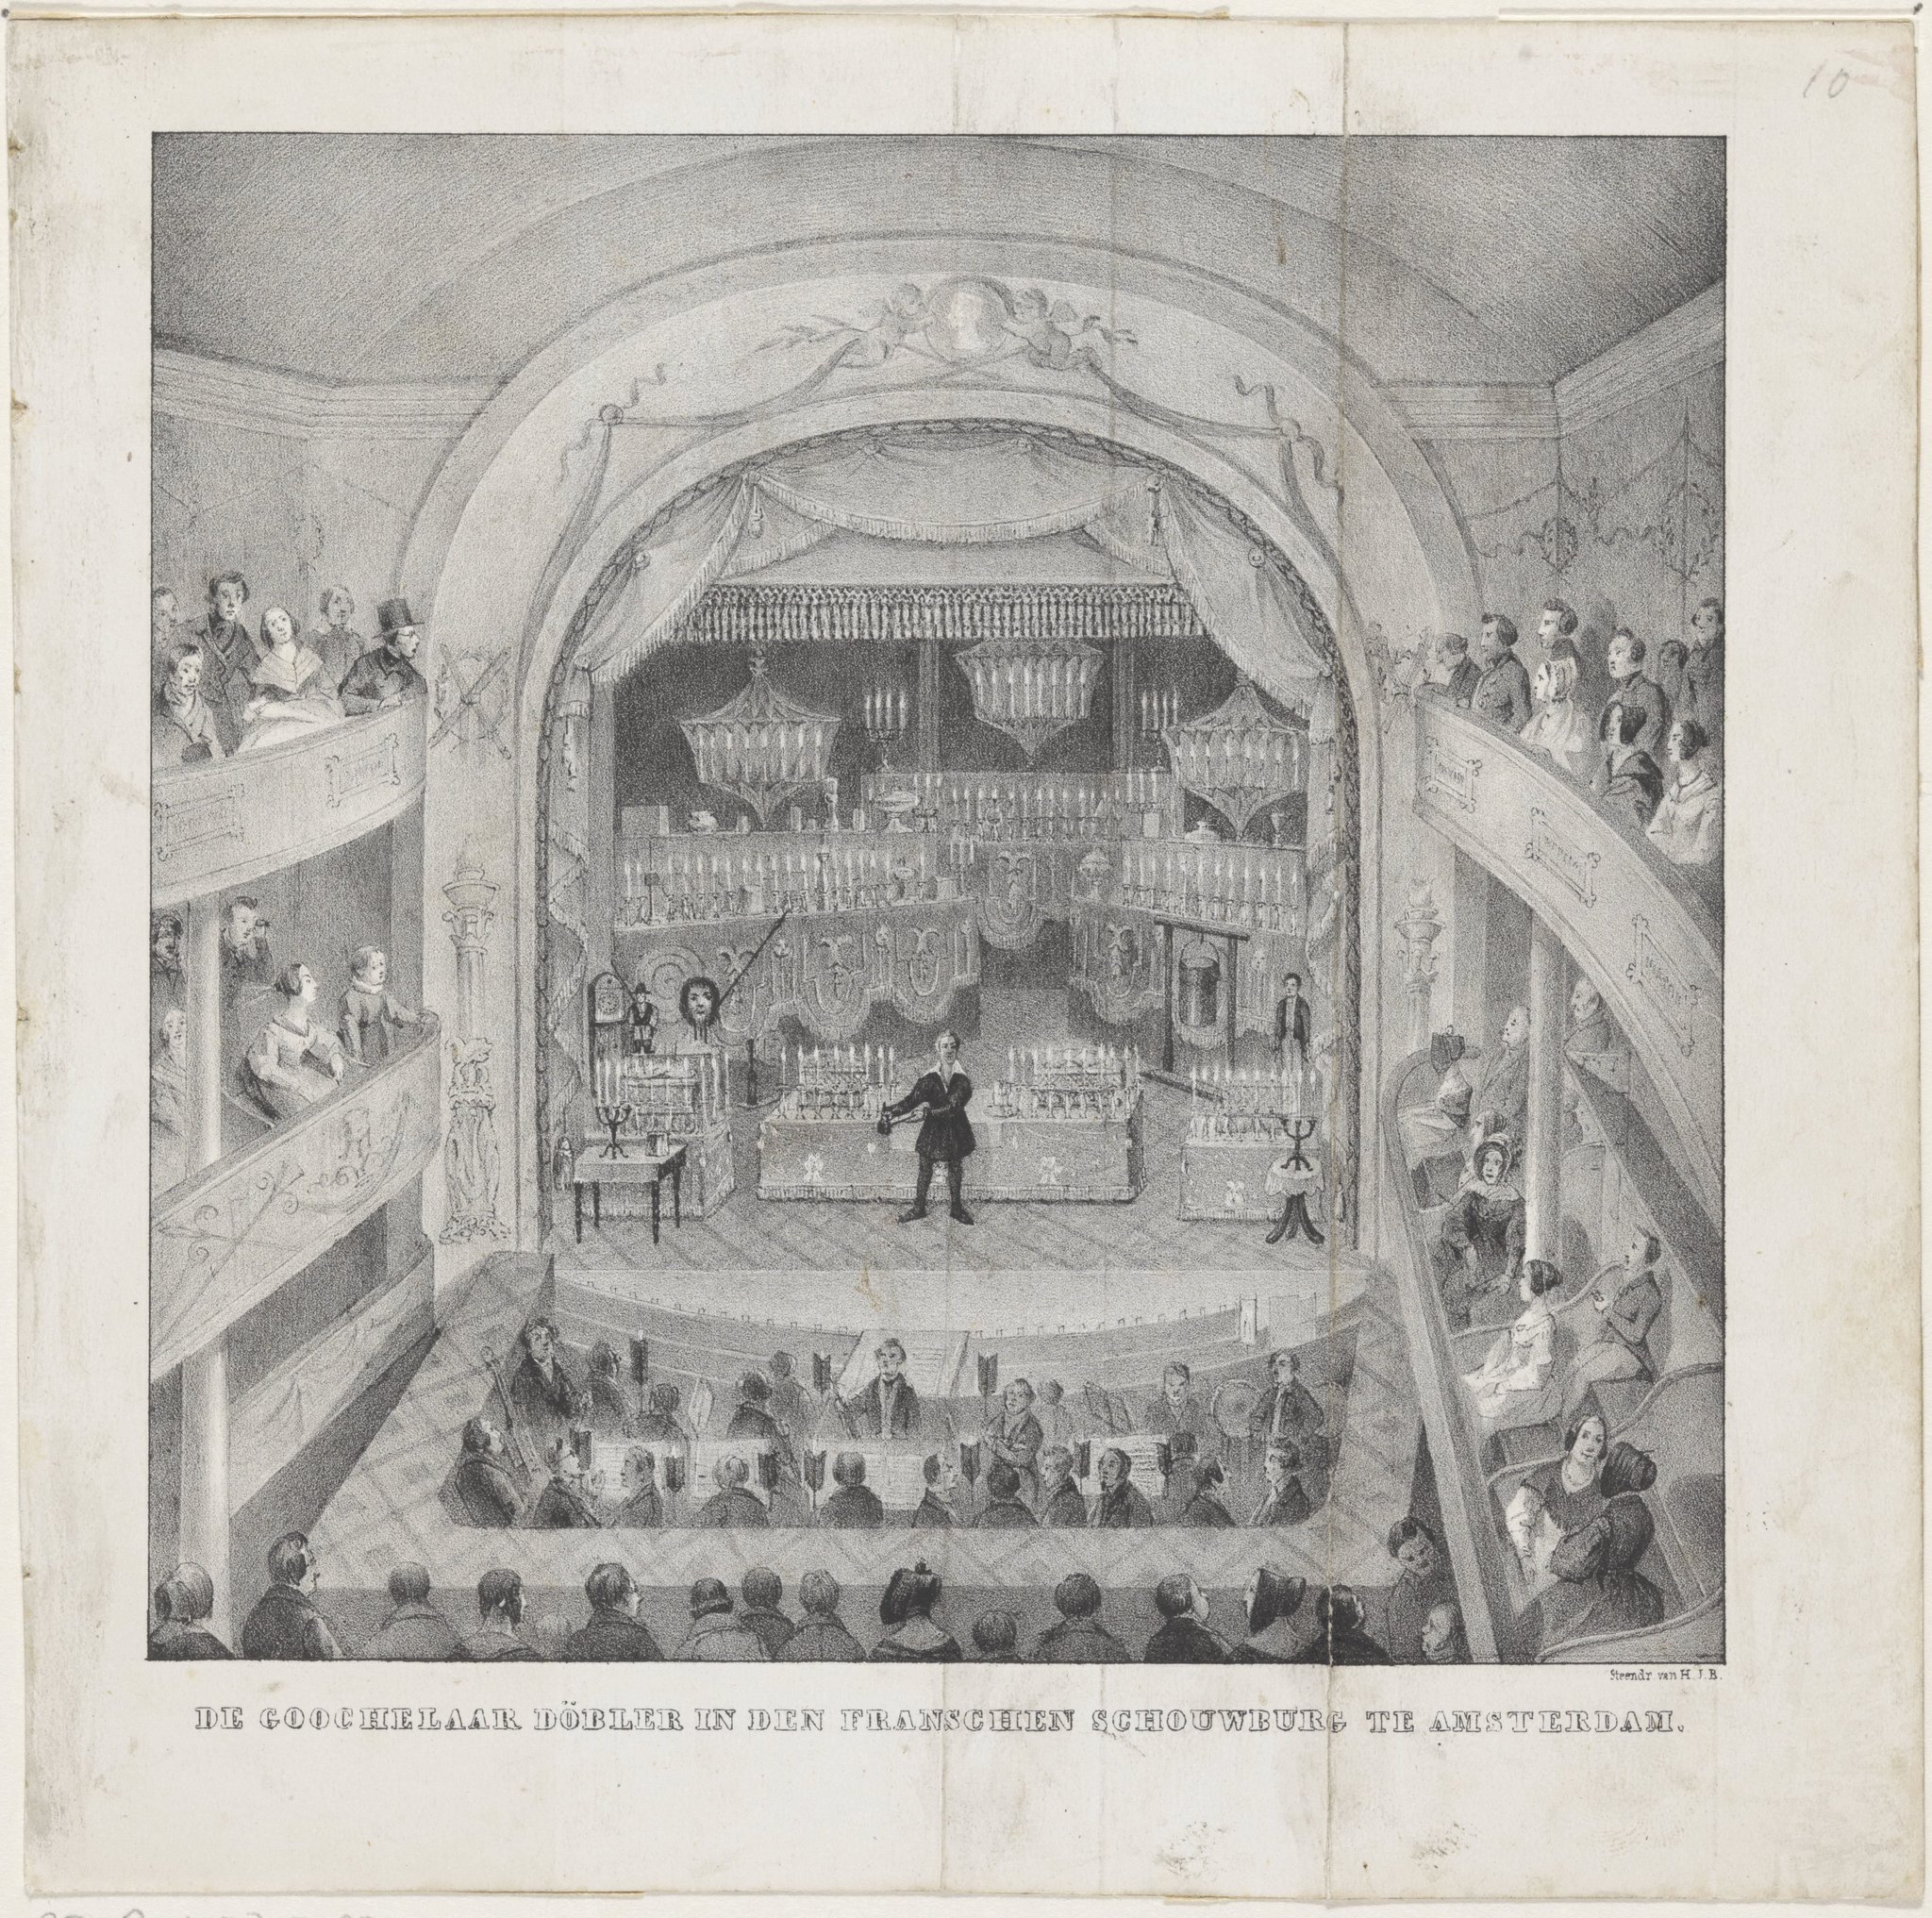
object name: print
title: Goochelaar in een schouwburg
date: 1822-1845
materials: paper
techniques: lithograph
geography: dordrecht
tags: boxes, loges ~ theatre, etc., large group of musicians, orchestra, sorcerer, magician, wizard, warlock, amsterdam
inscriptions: collector's mark: Lugt 2228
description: Op het podium staat een goochelaar te midden van attributen en kaarsen. Voor hem het orkest in de orkestbak. In de zaal en op de balkons zit publiek.